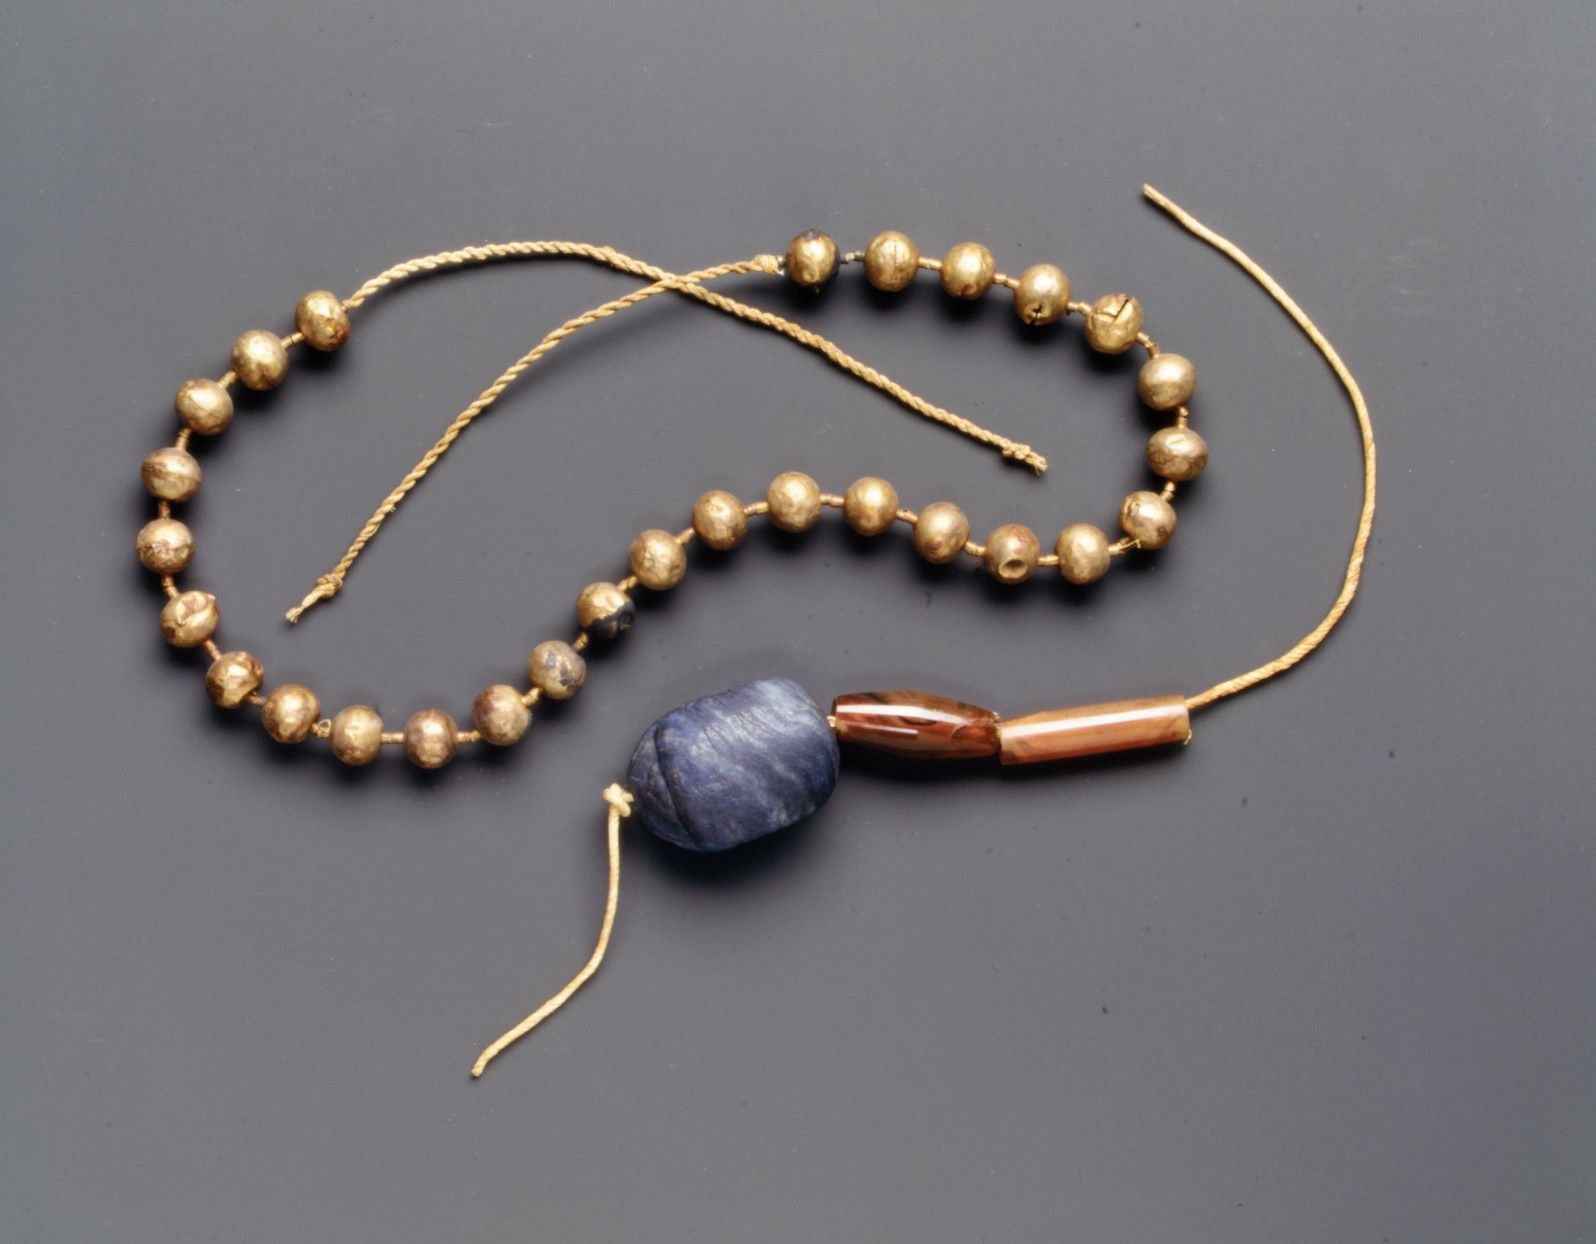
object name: necklace, wah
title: Necklace of Gold Ball Beads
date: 1981-1975 BCE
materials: cord, gold, linen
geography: egypt